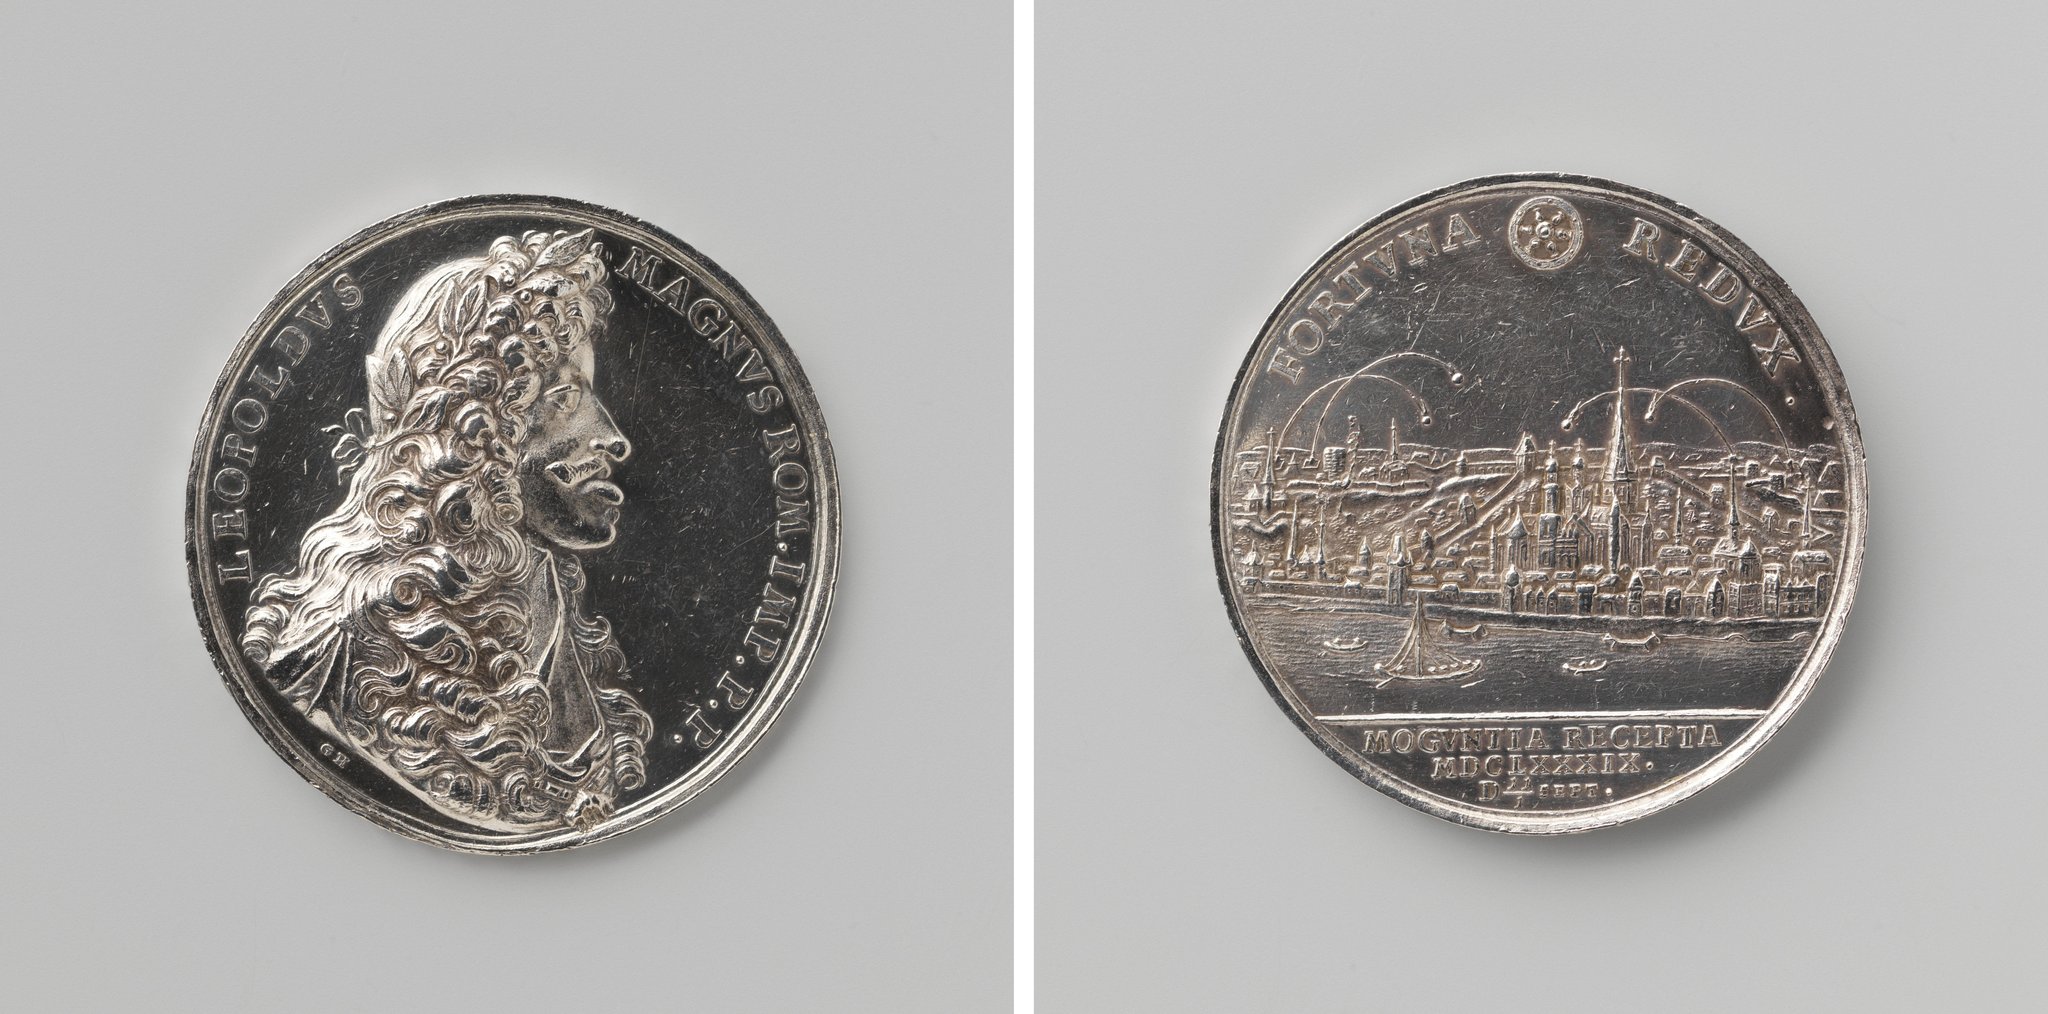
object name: history medal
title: Inname van Mainz, ter ere van Leopold I, Duits keizer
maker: georg hautsch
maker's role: medailleur, muntmaker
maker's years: 1679-1745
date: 1689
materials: silver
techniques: striking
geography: nuremberg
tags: leopold i (keizer van duitsland)